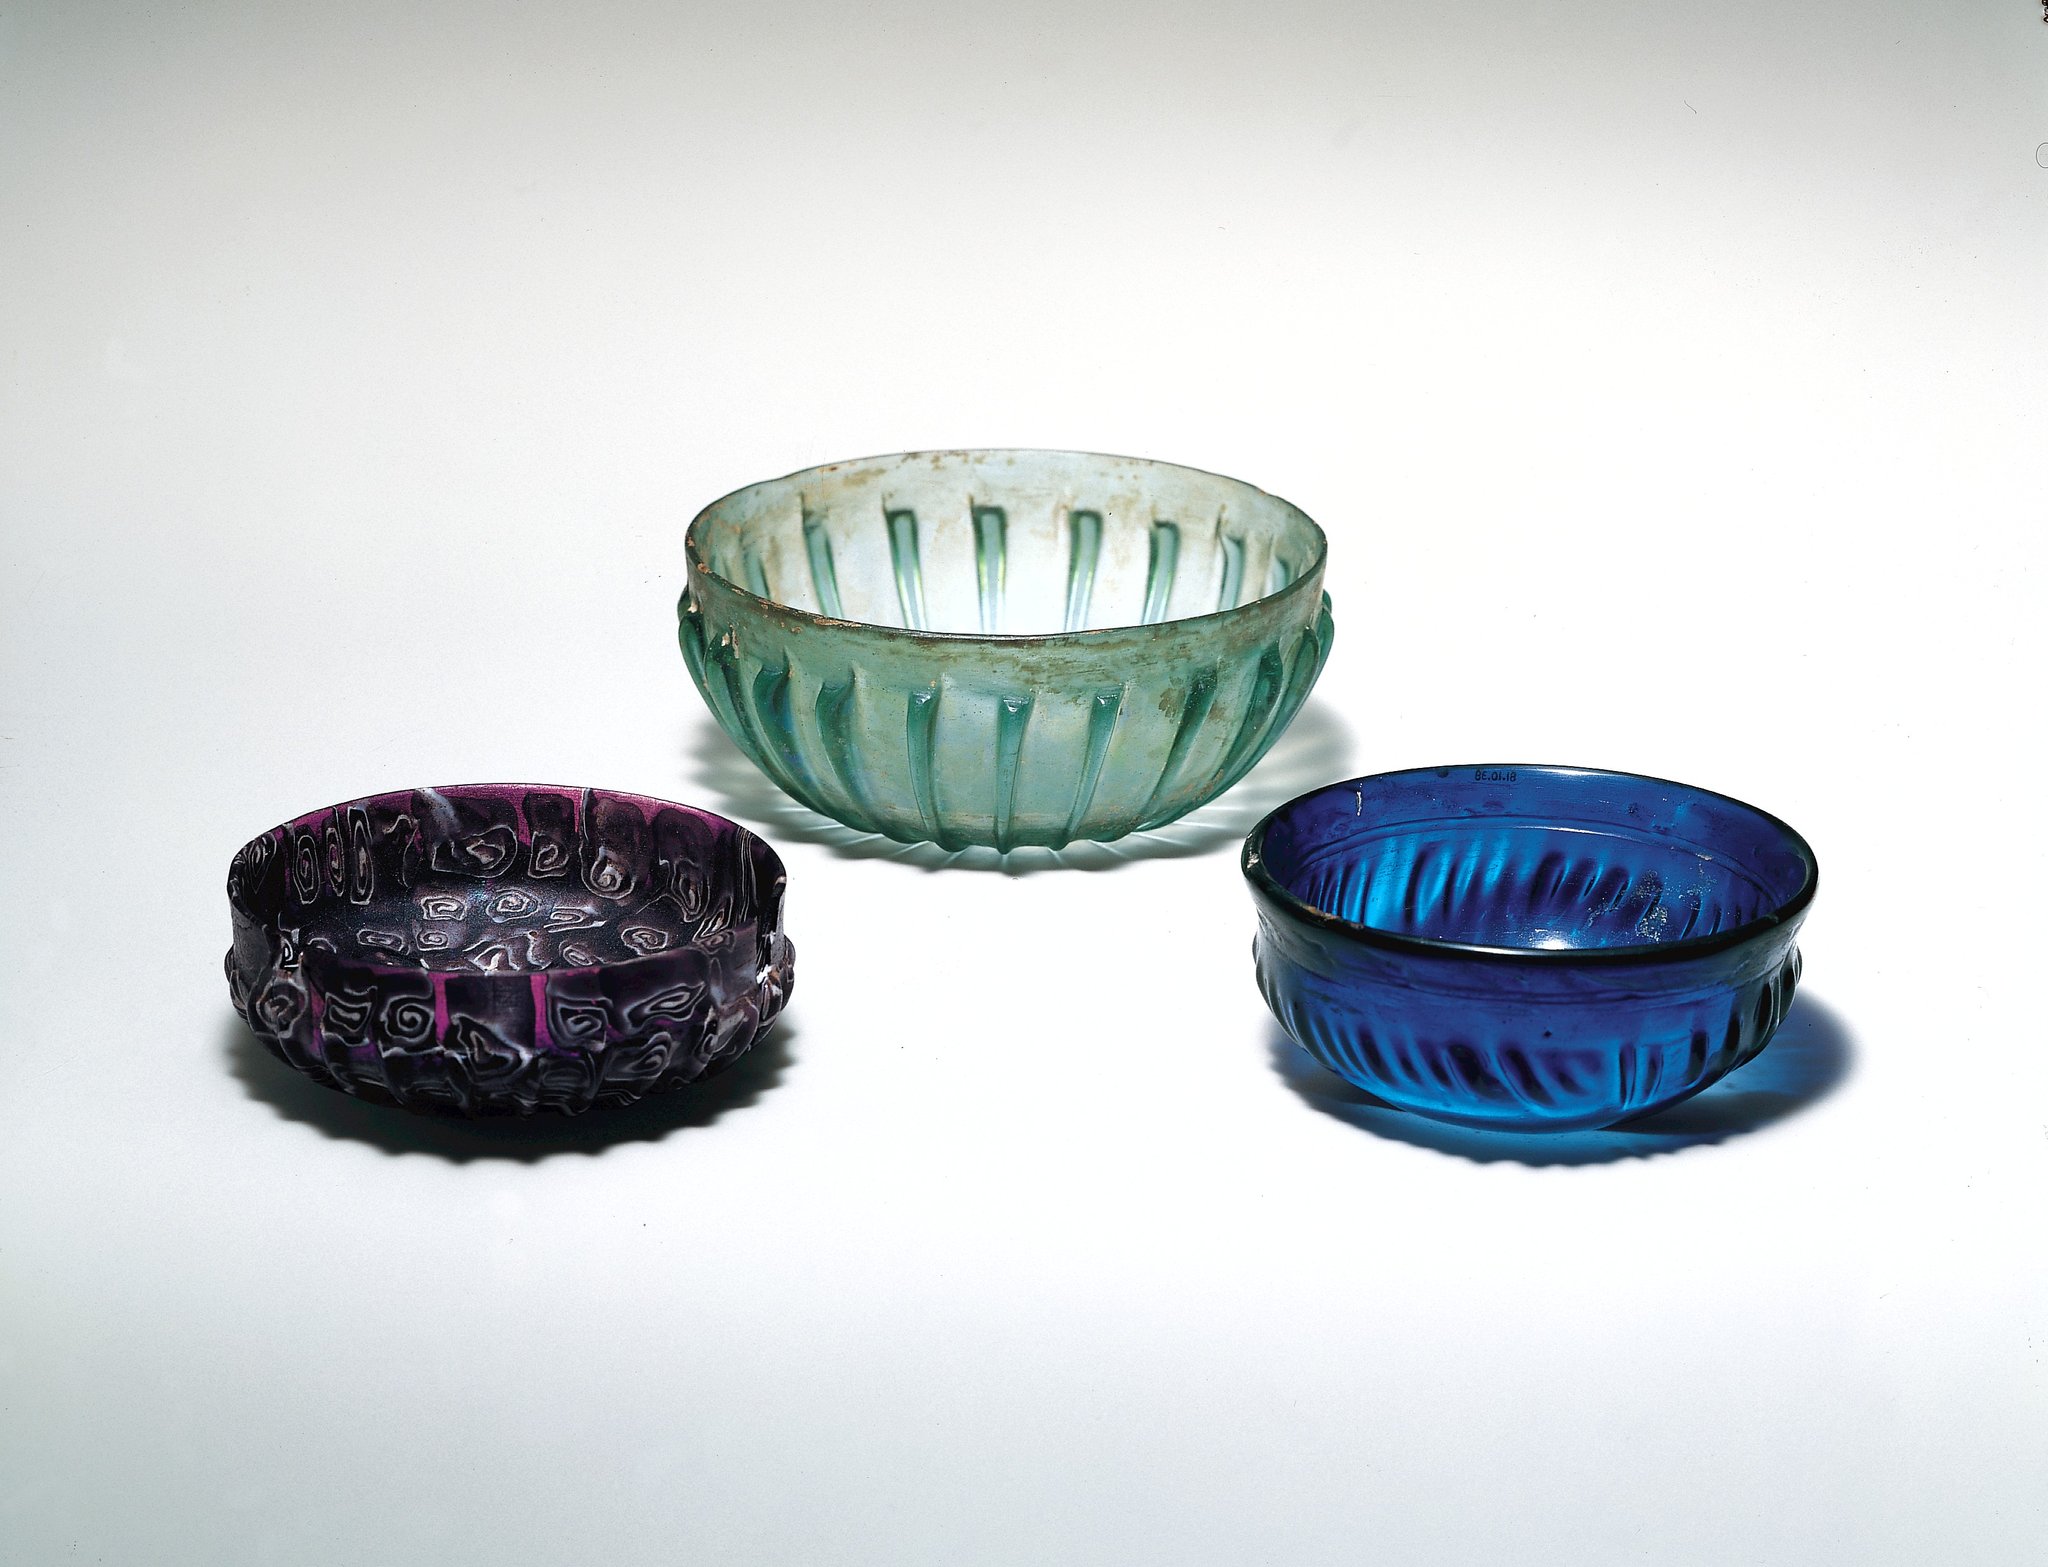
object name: bowl, ribbed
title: Glass ribbed bowl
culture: roman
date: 1-50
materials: glass